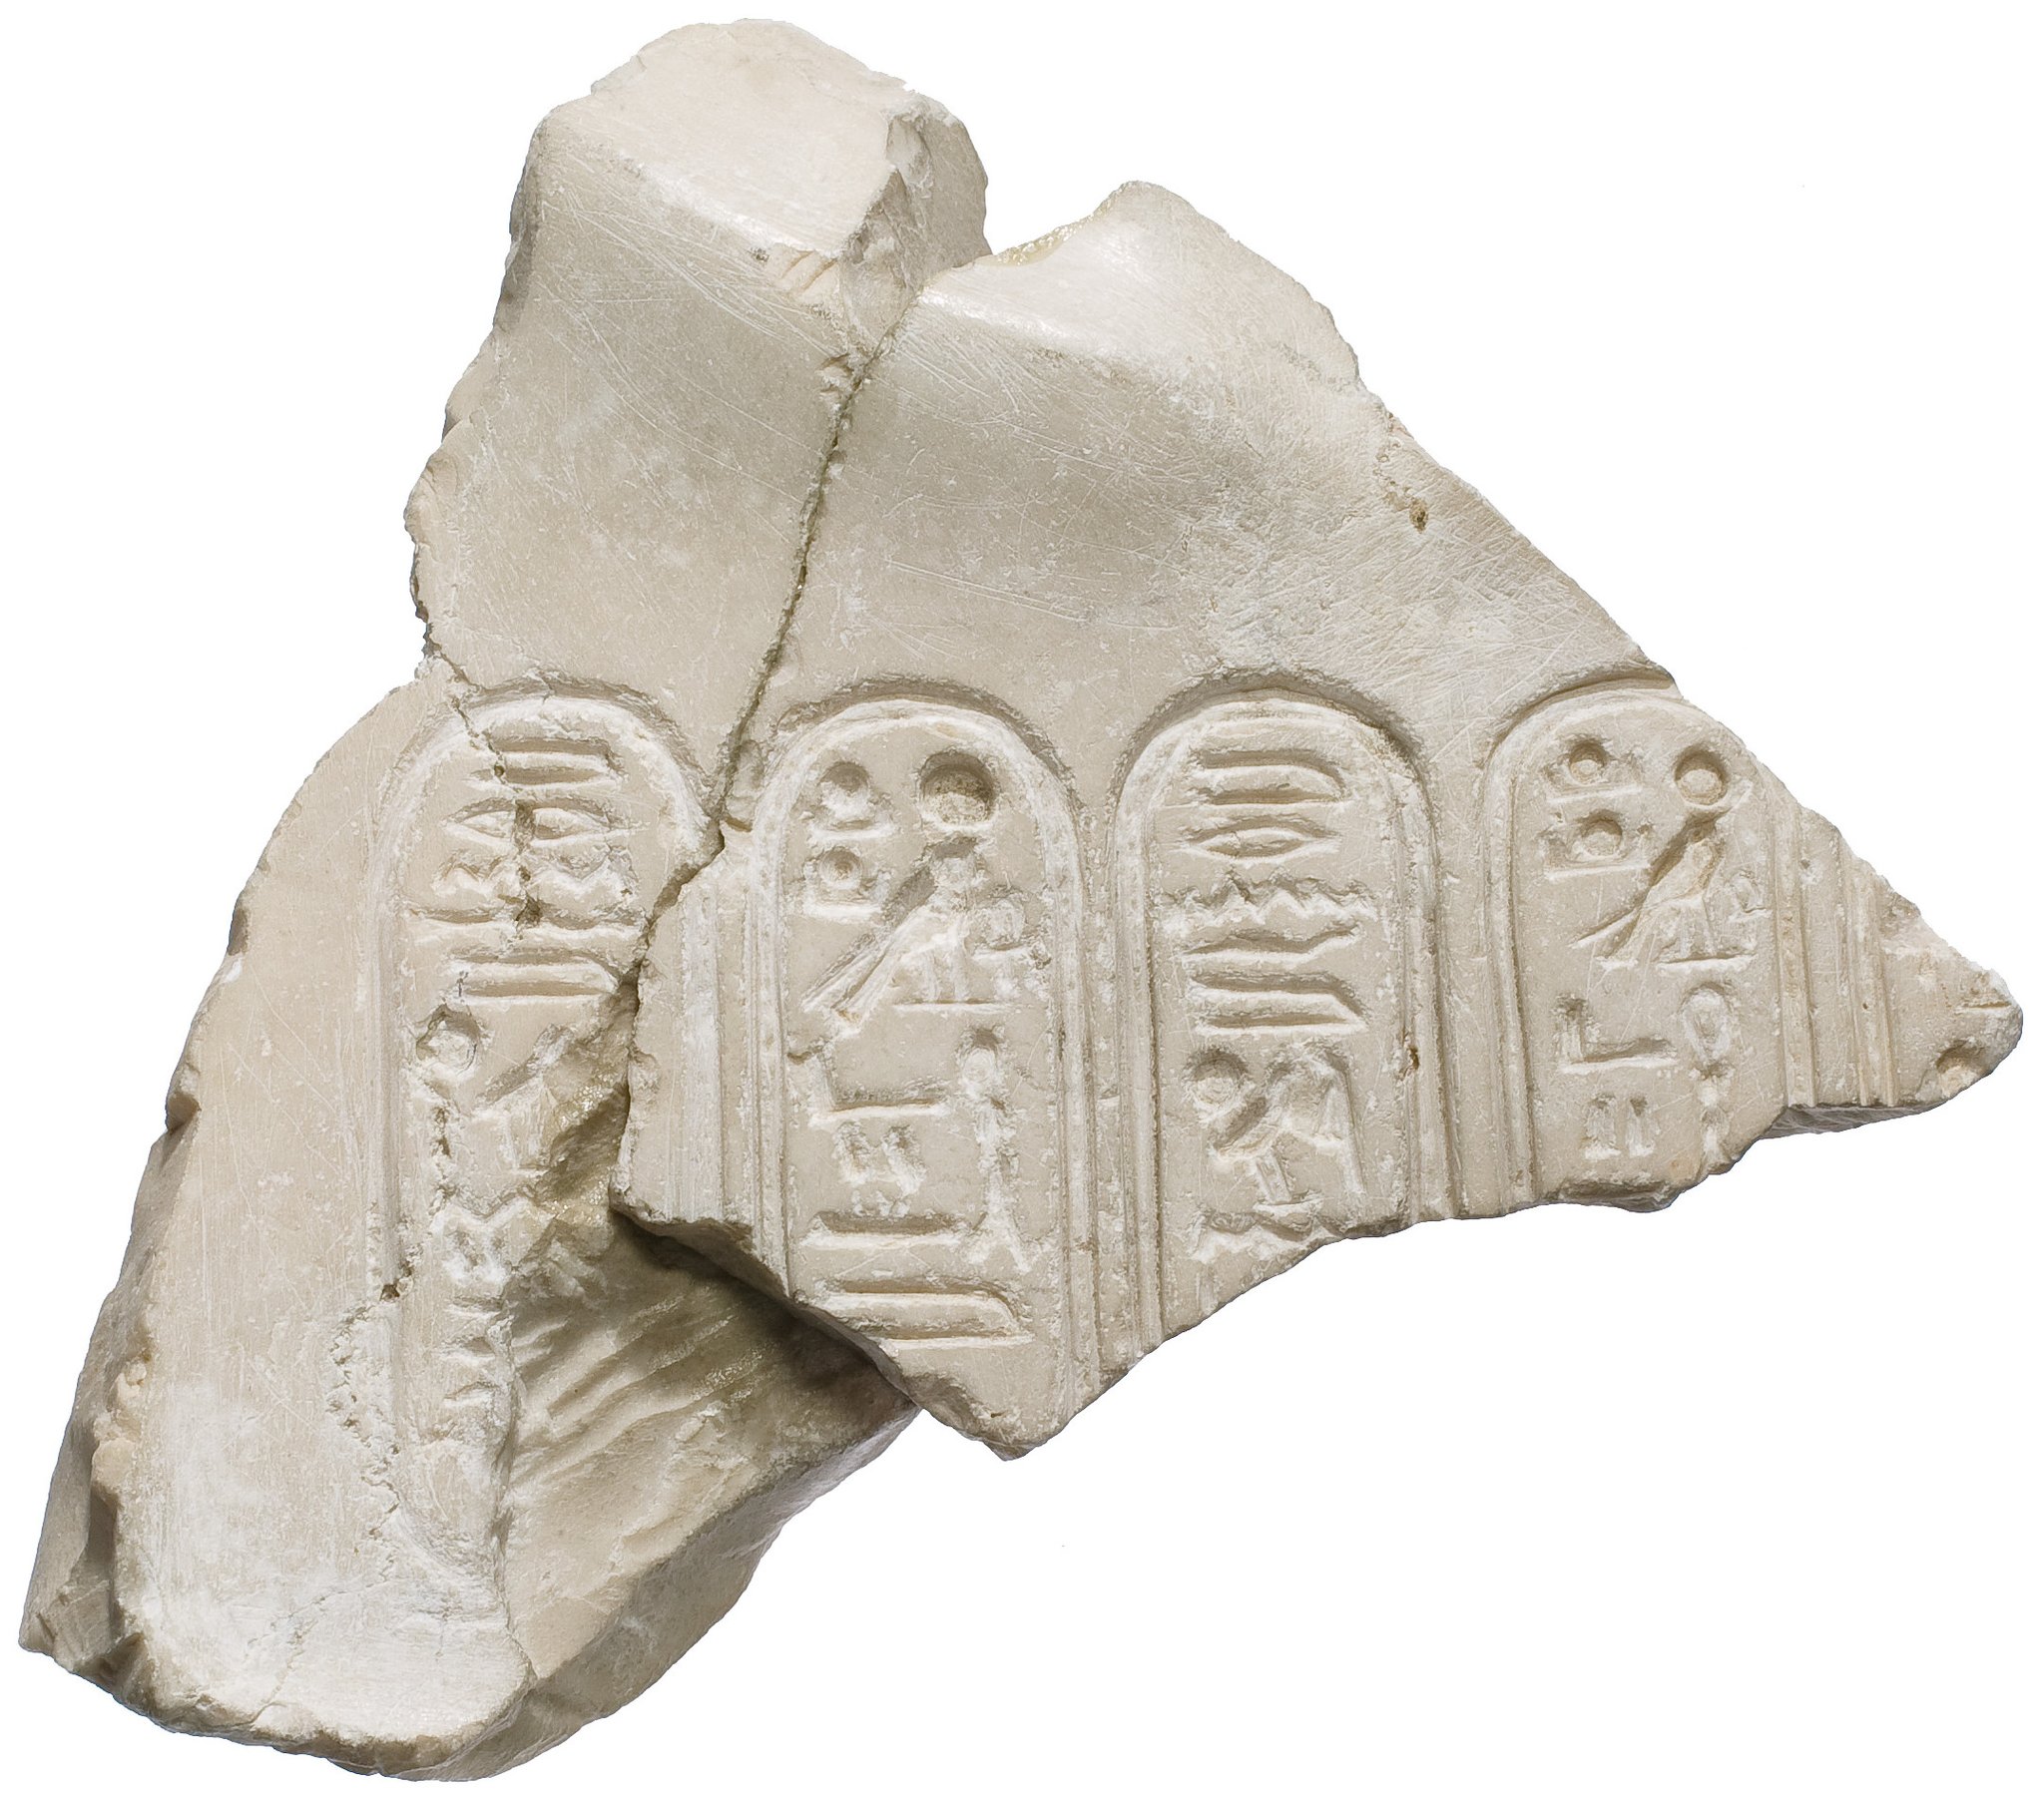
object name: akhenaten prostrate, right chest, aten cartouch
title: Right chest of Akhenaten prostrate with Aten cartouches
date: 1352-1336 BCE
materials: limestone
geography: egypt